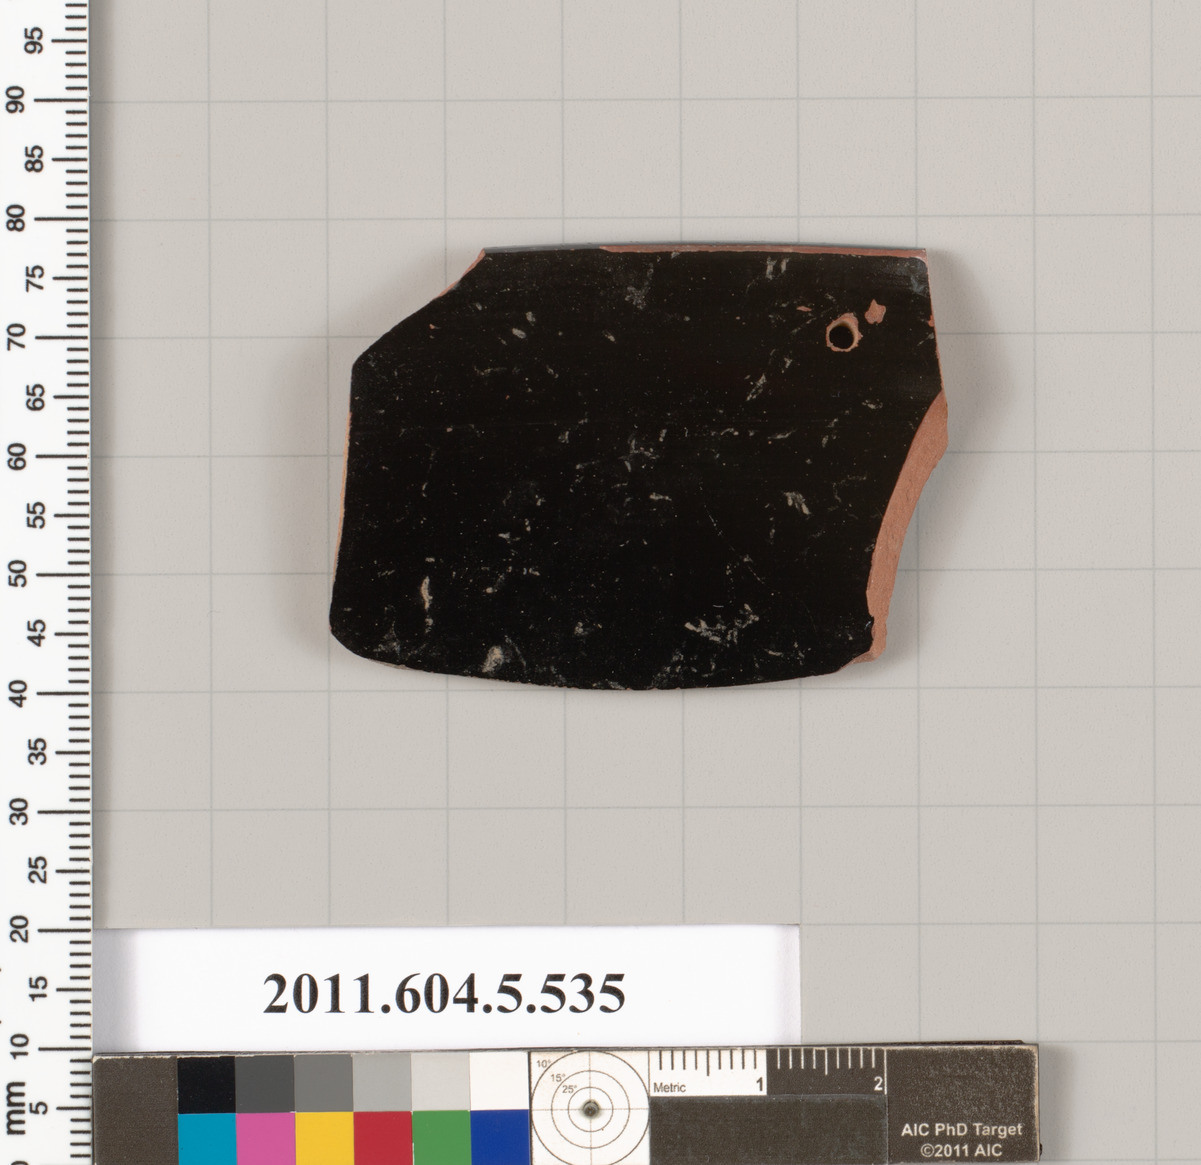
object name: kylix fragment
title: Terracotta rim fragment of a kylix (drinking cup)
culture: greek, attic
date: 600-401 BCE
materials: terracotta